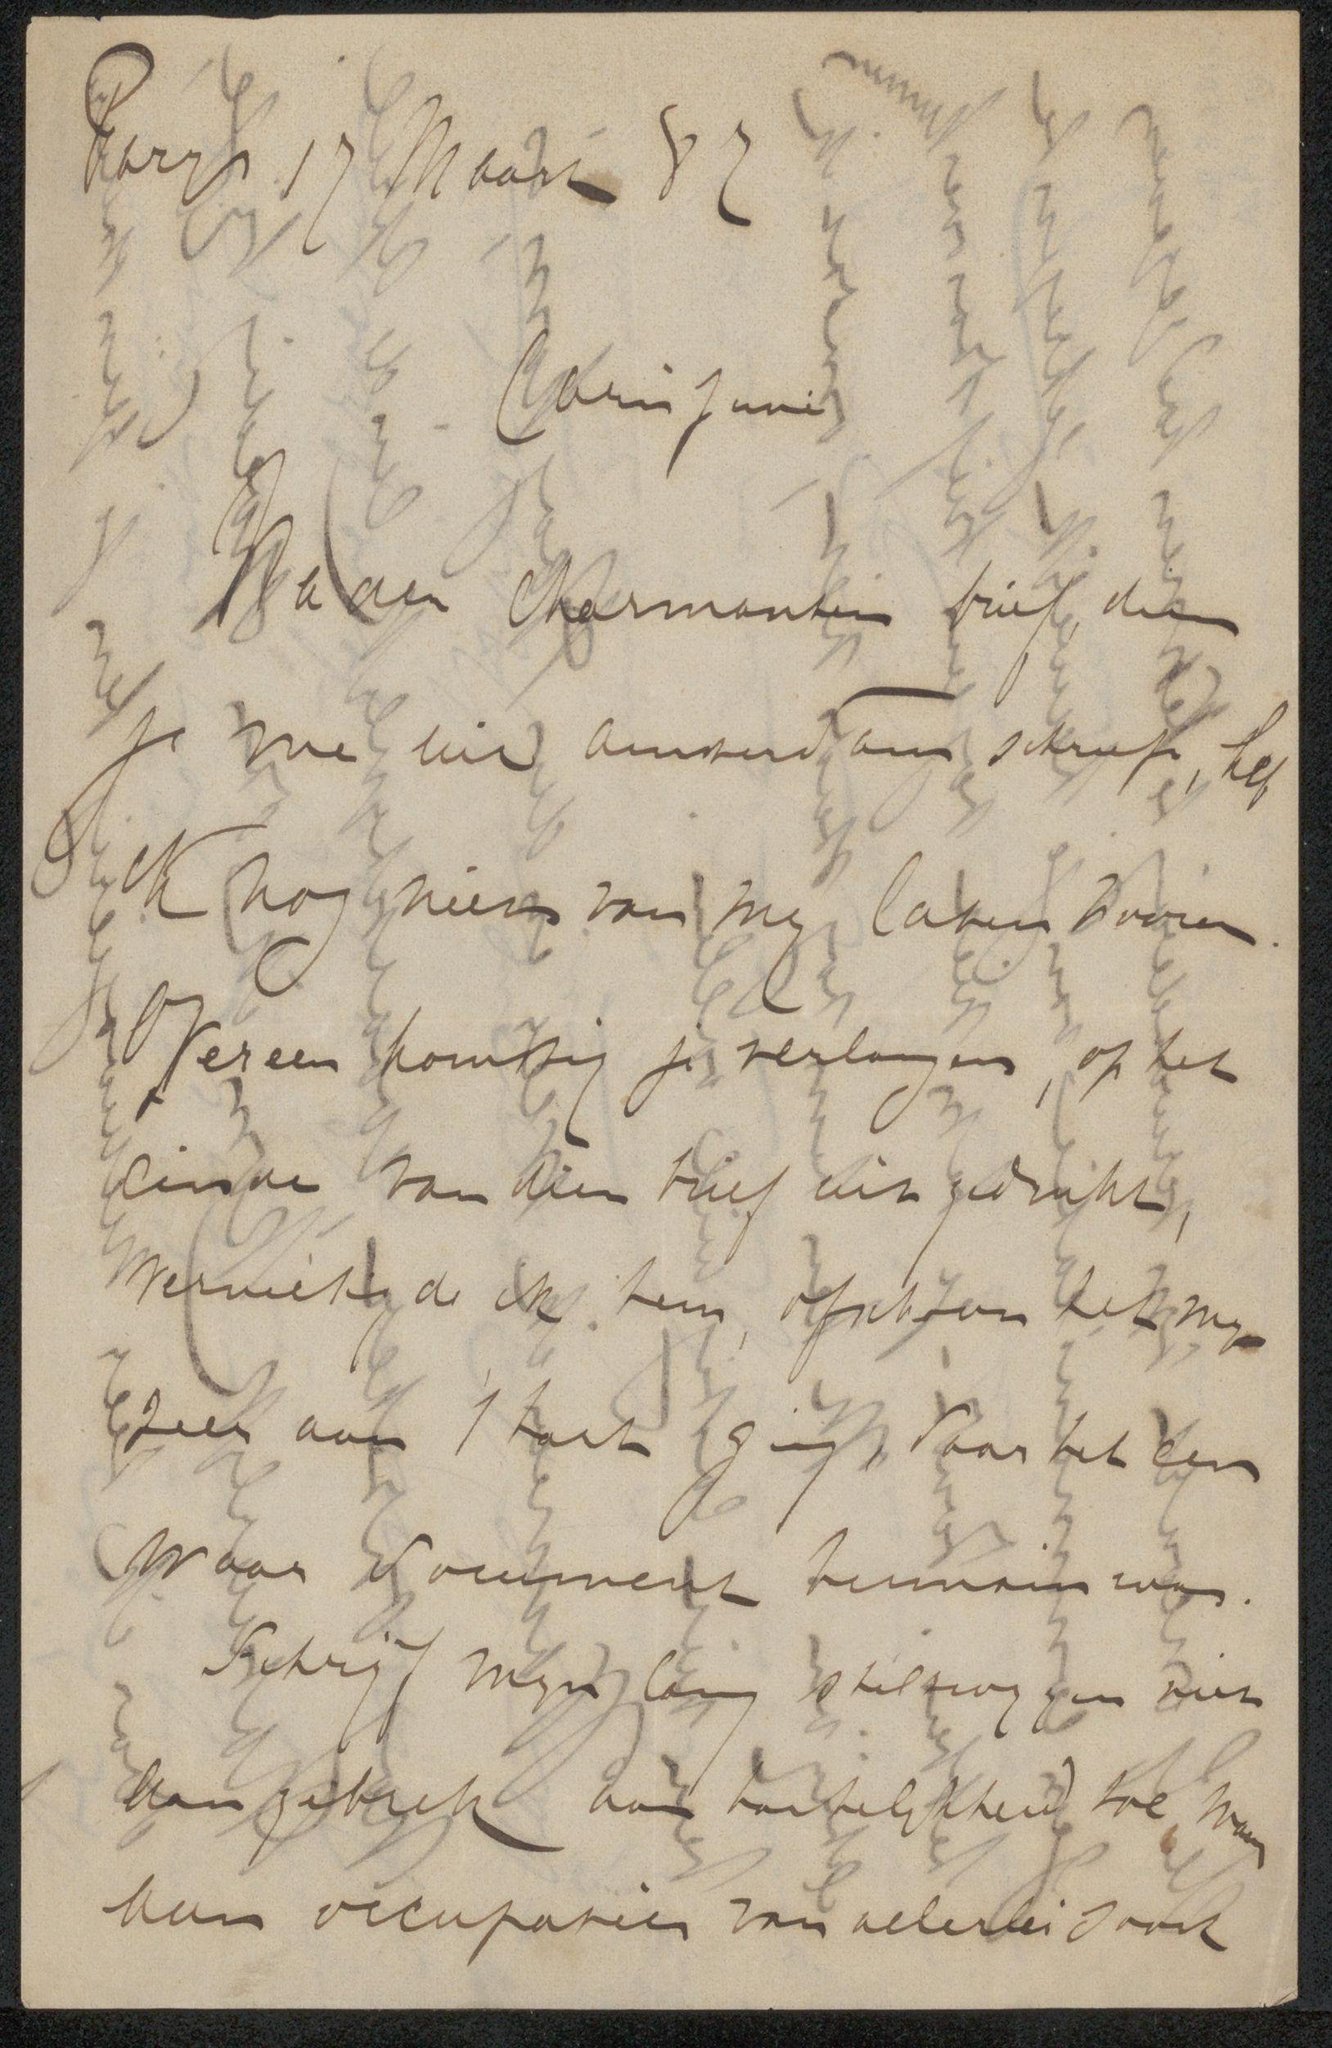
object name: letter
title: Brief aan Philip Zilcken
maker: adriaan pit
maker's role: print maker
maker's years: 1860-1944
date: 1887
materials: ink, paper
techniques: pen, writing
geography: paris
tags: marinus van der maarel, painter, draughtsman, edmond de goncourt, philip zilcken, passions, emotions, affections, the hague, amsterdam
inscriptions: collector's mark: ‘RPK’